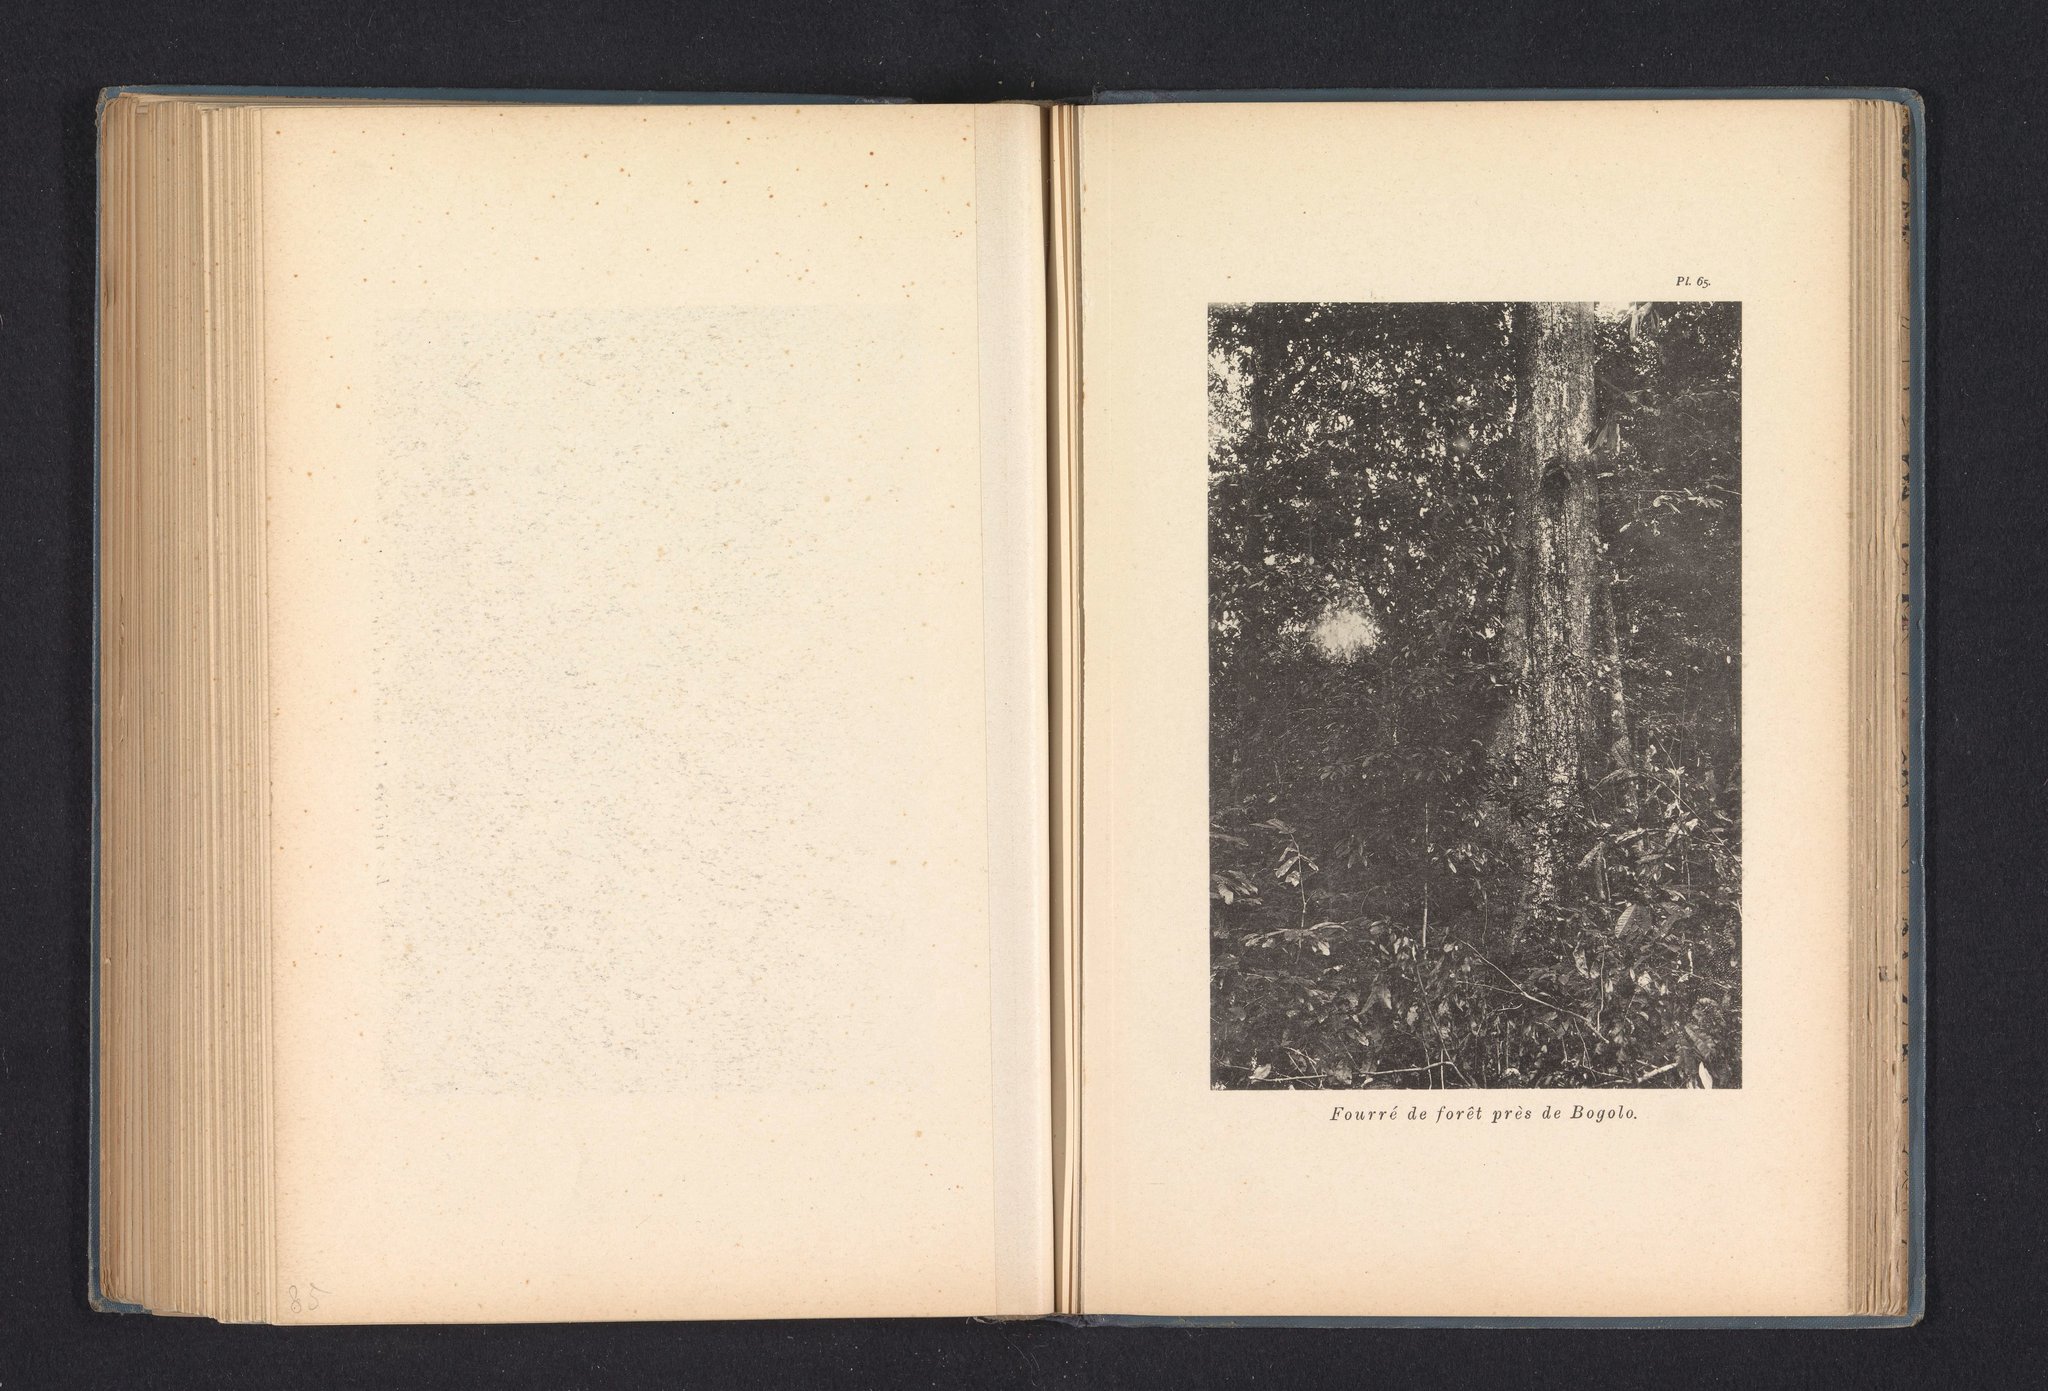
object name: photomechanical print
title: Struikgewas nabij Bogolo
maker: franz thonner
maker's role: botanicus, ontdekkingsreiziger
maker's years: 1863-1928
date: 1896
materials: paper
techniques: photograph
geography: congo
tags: shrubs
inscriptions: number: ‘Pl. 65.’